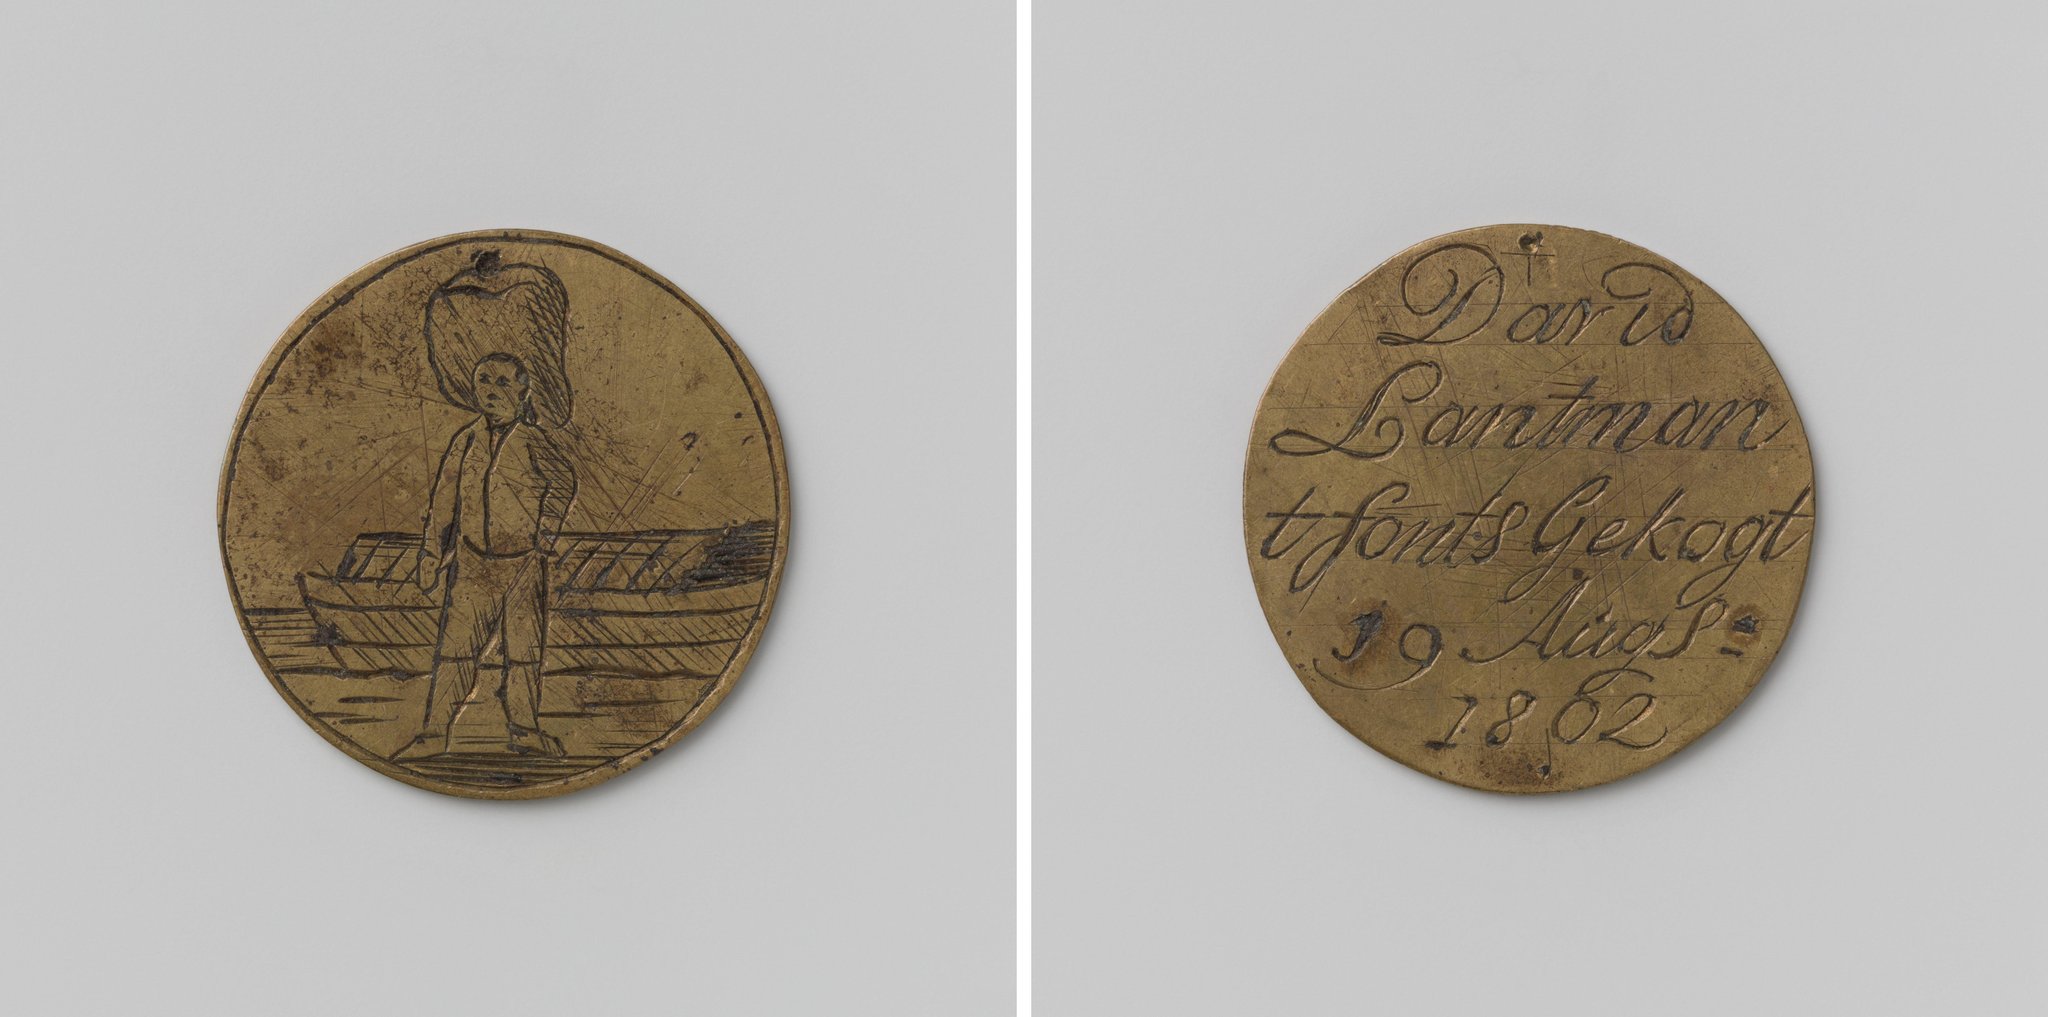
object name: medal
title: Korendragers- en -stortersgilde van Amsterdam, gildepenning van David Lantman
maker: Anonymous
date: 1802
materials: brass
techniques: engraving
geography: amsterdam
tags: amsterdam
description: Messing penning. Voorzijde: lichtelijk naar links gewende man met last op hoofd; op achtergrond: lichterschuit. Keerzijde: opschrift